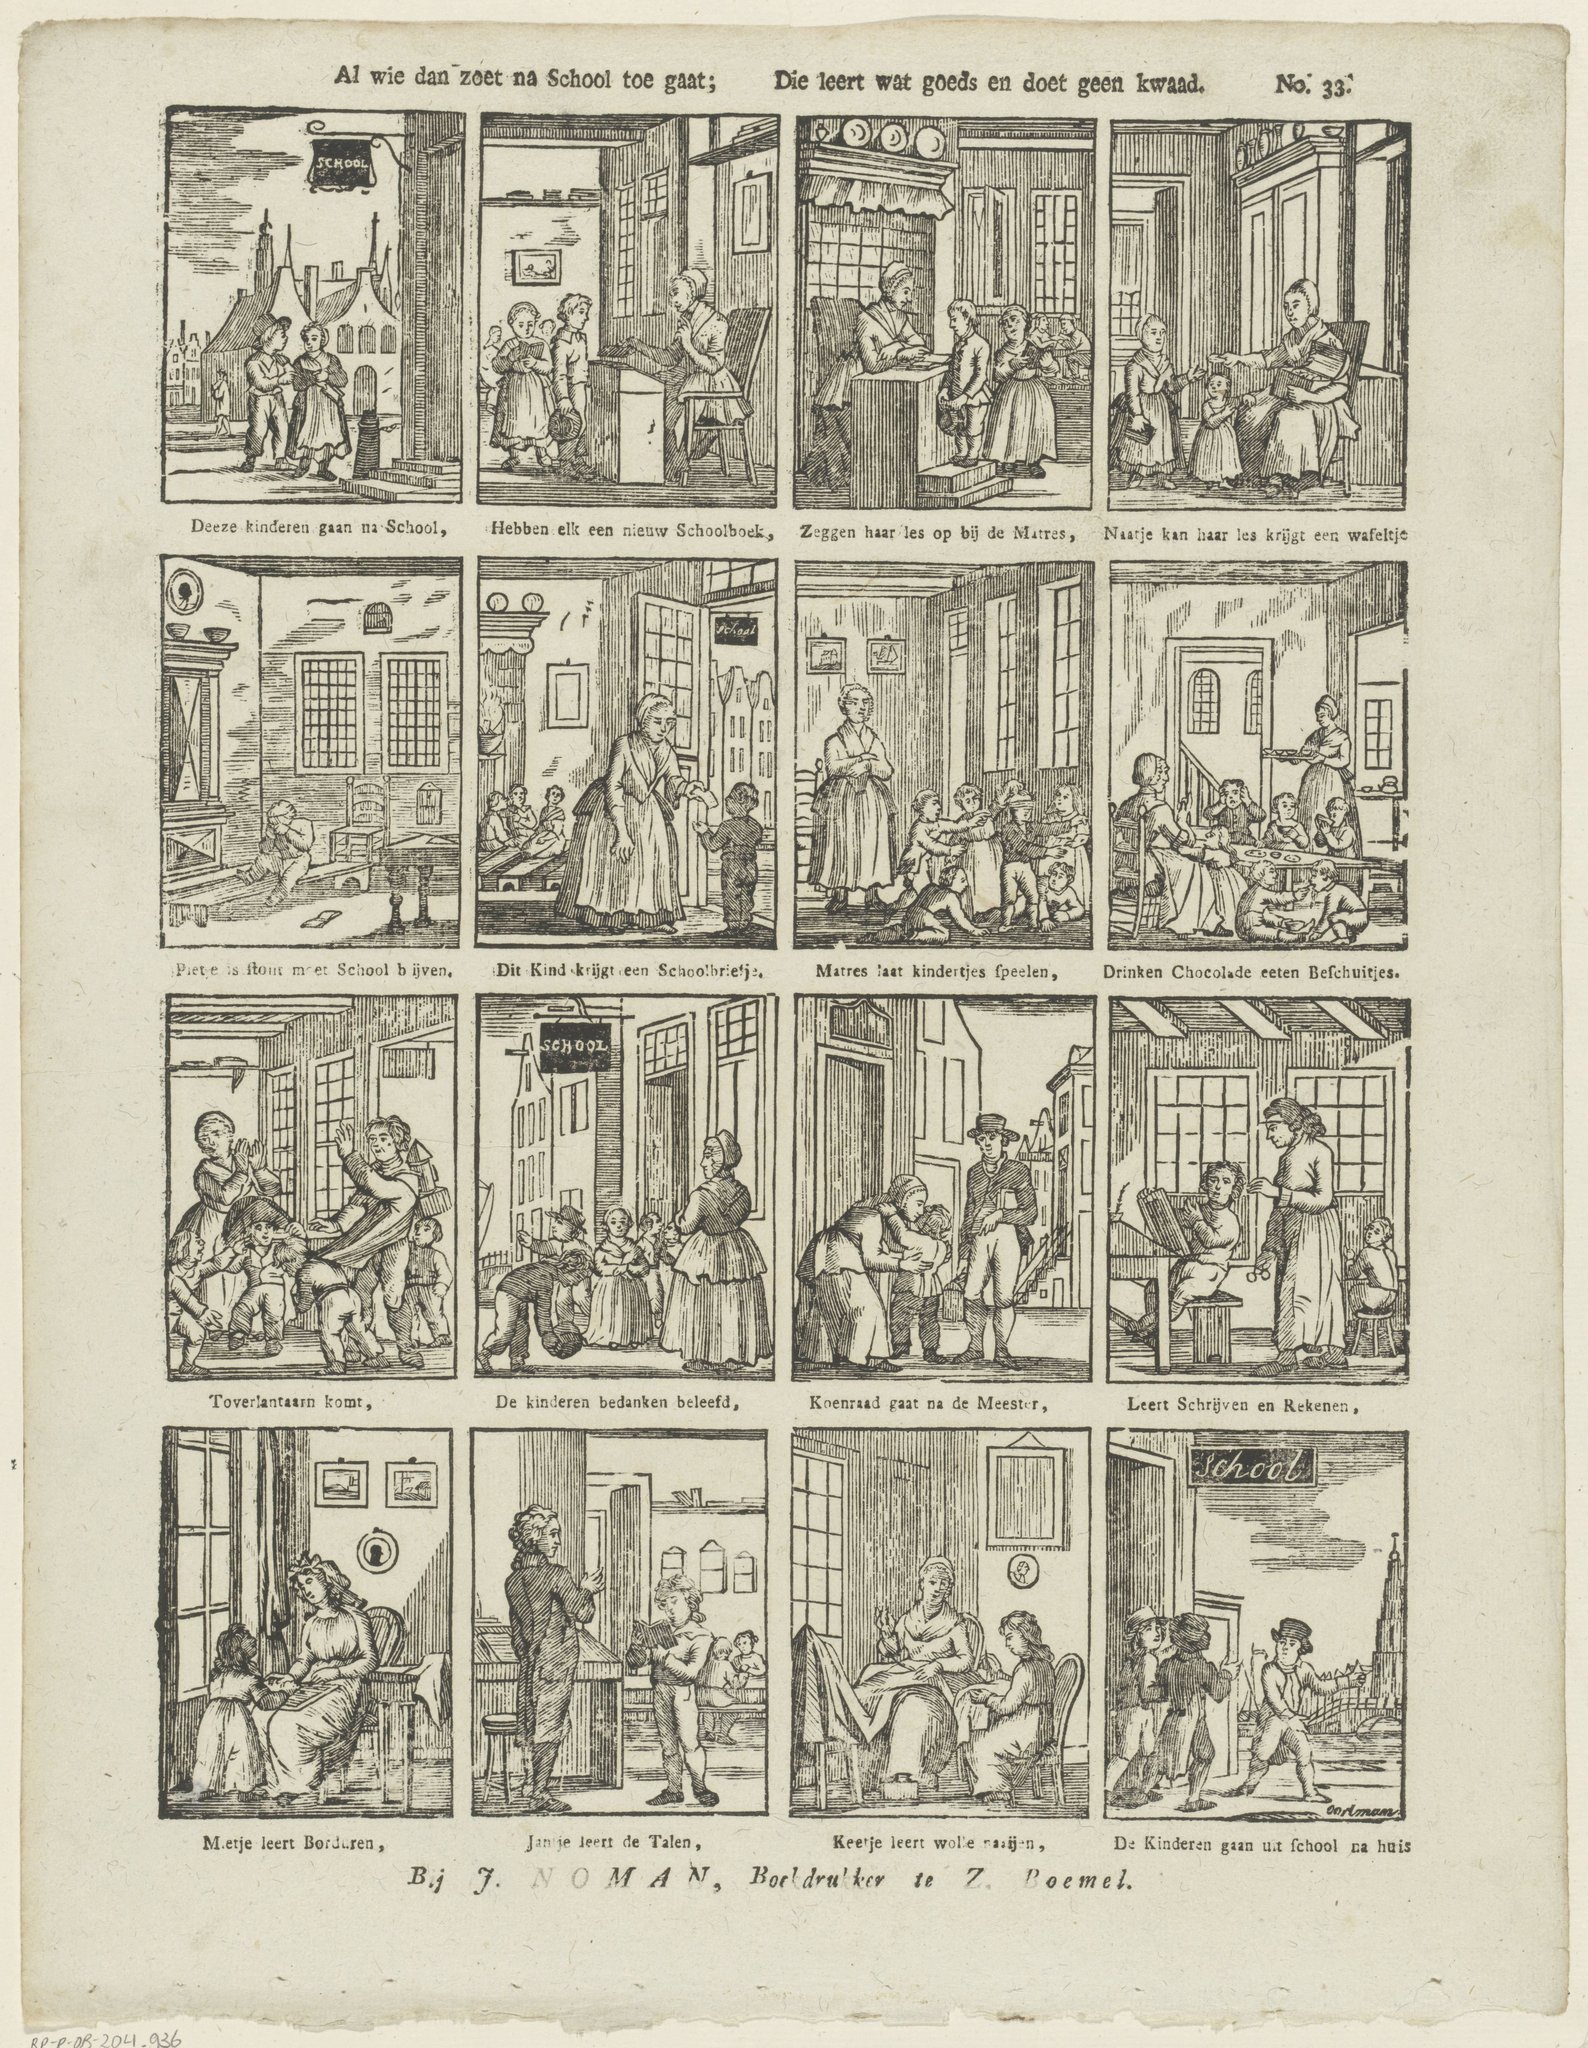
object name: popular print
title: Al wie dat zoet na school toe gaat, / Die leert wat goeds en doet geen kwaad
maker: johan noman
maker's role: printer, publisher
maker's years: -1833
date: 1806-1830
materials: paper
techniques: letterpress printing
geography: zaltbommel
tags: education, science and learning, going to school, child, good behaviour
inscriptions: collector's mark: Lugt 2760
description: Blad met 16 voorstellingen van schoolgaande kinderen. Onder elke afbeelding een onderschrift. Genummerd rechtsboven: No. 33.